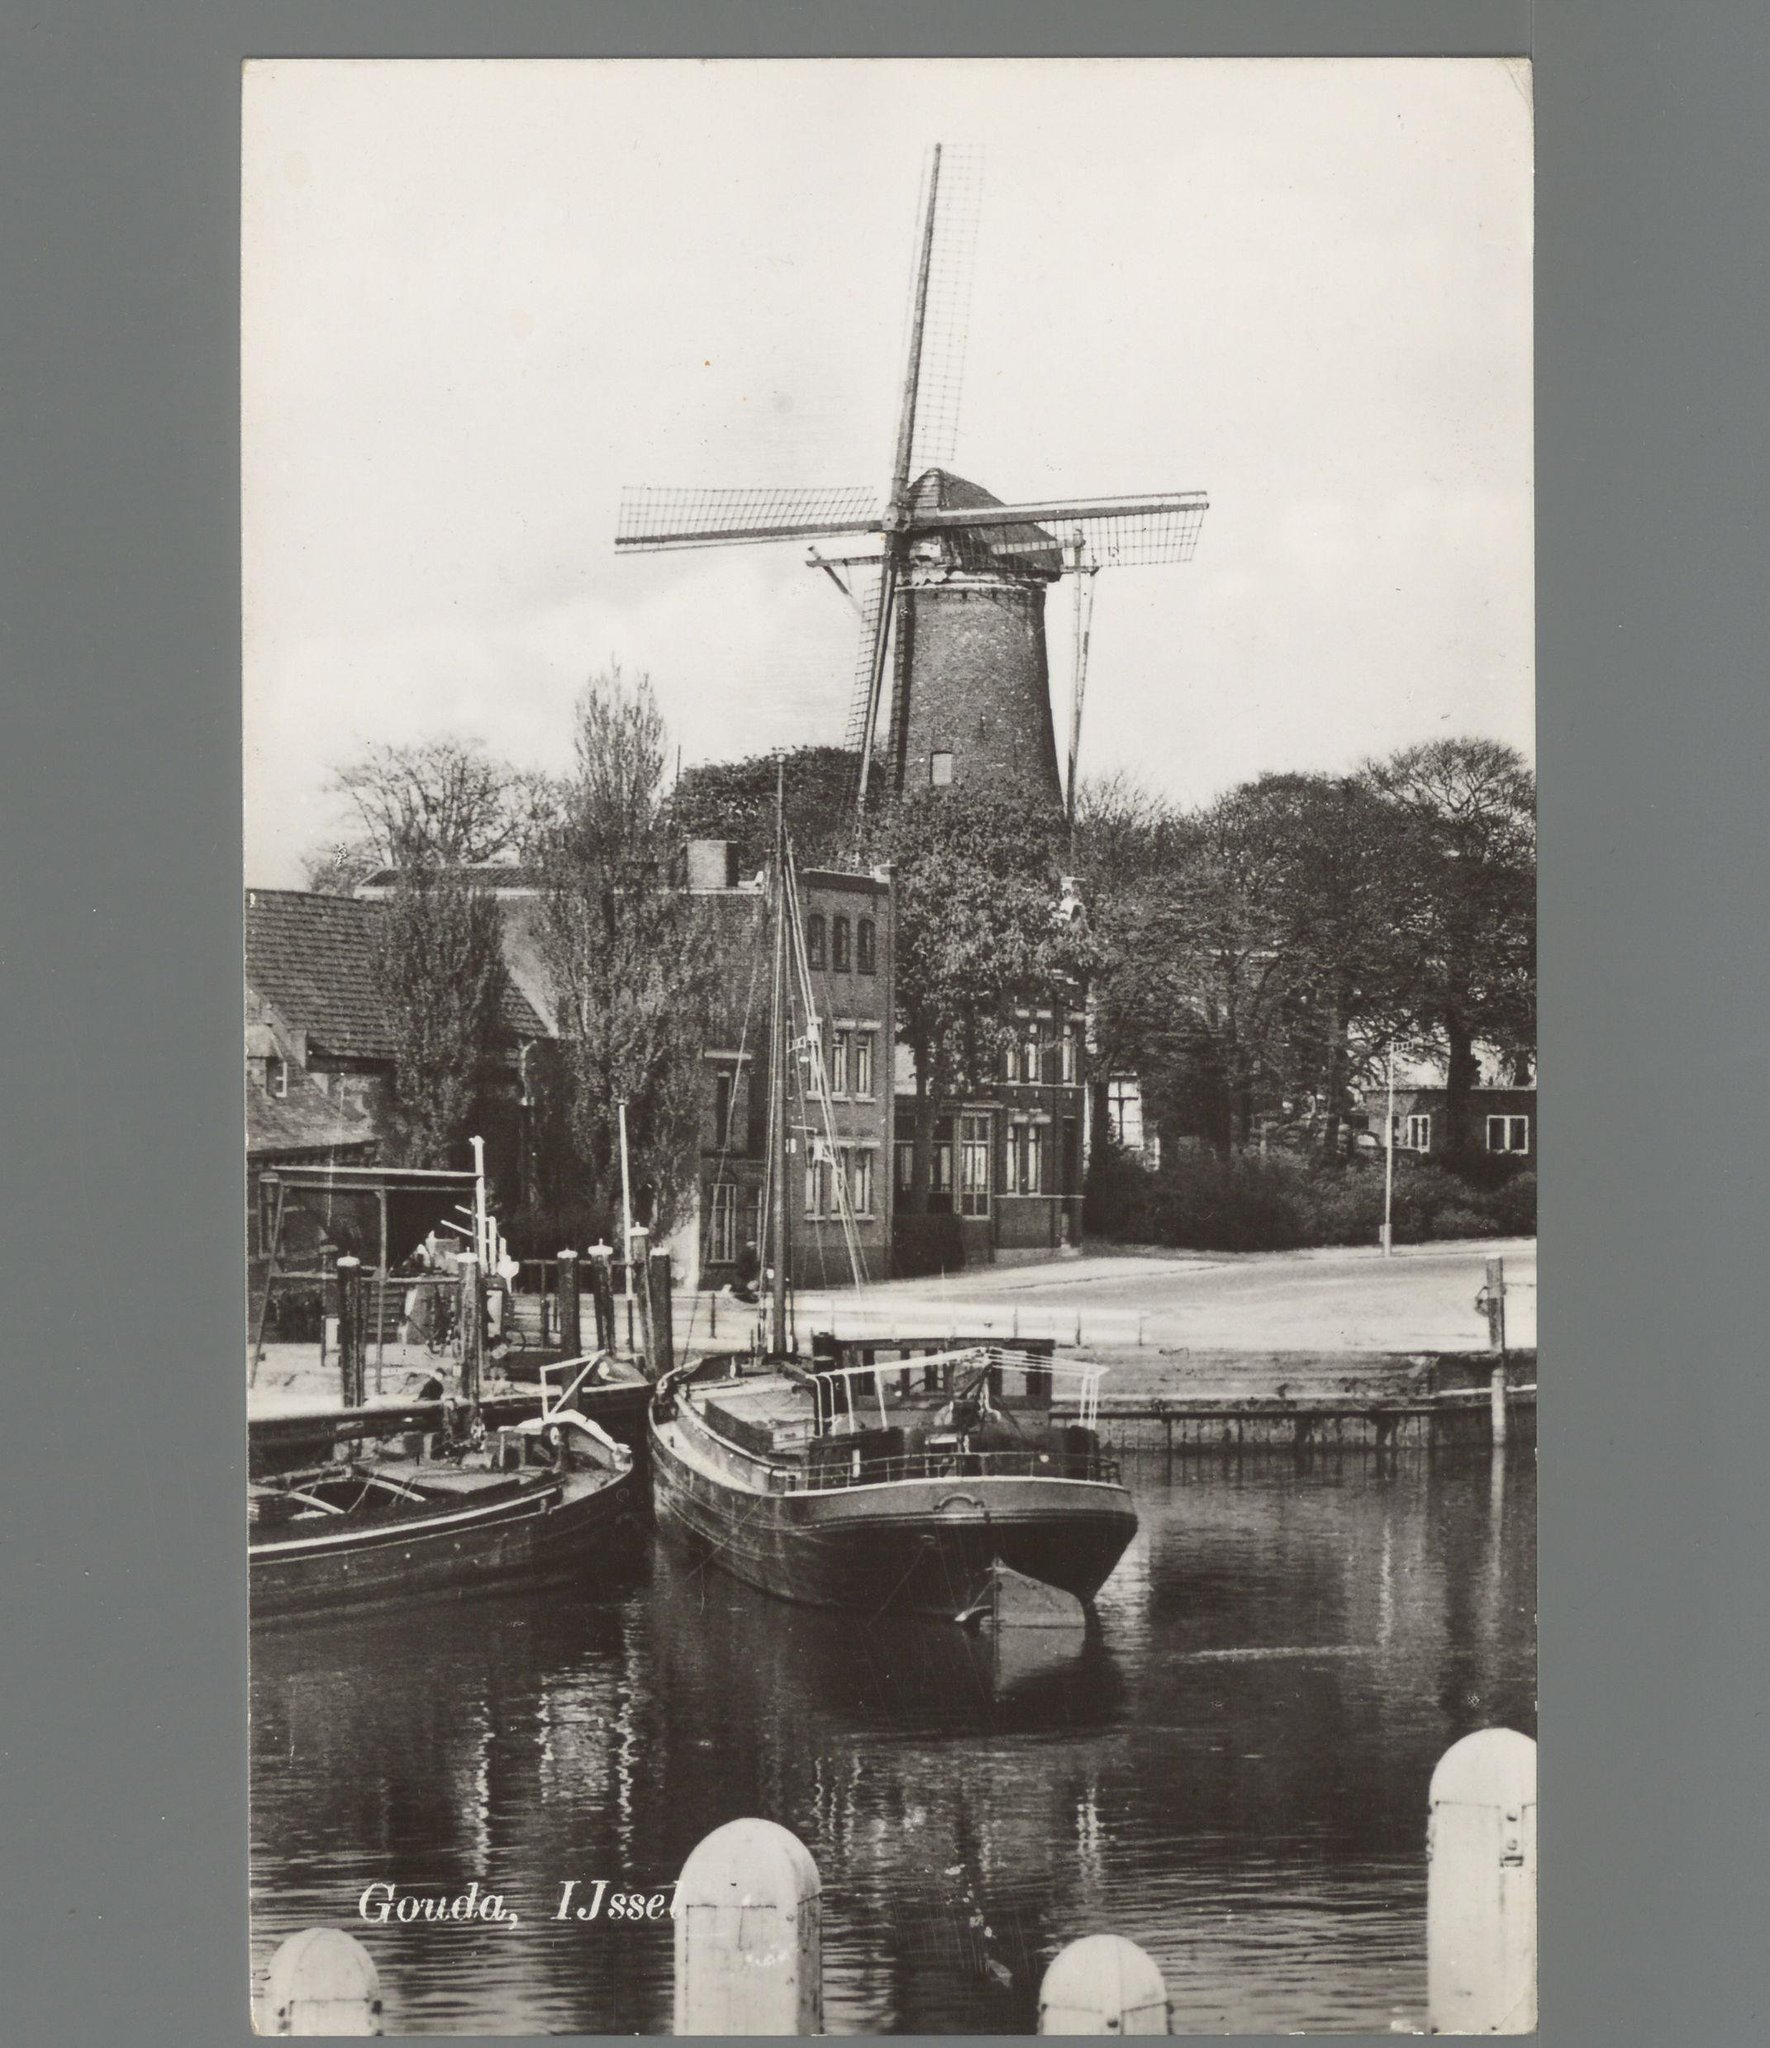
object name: photograph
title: Gouda, IJssel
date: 1900-1930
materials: photographic support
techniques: photography, writing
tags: city-view in general; 'veduta', windmill in landscape, gouda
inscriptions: postage stamp